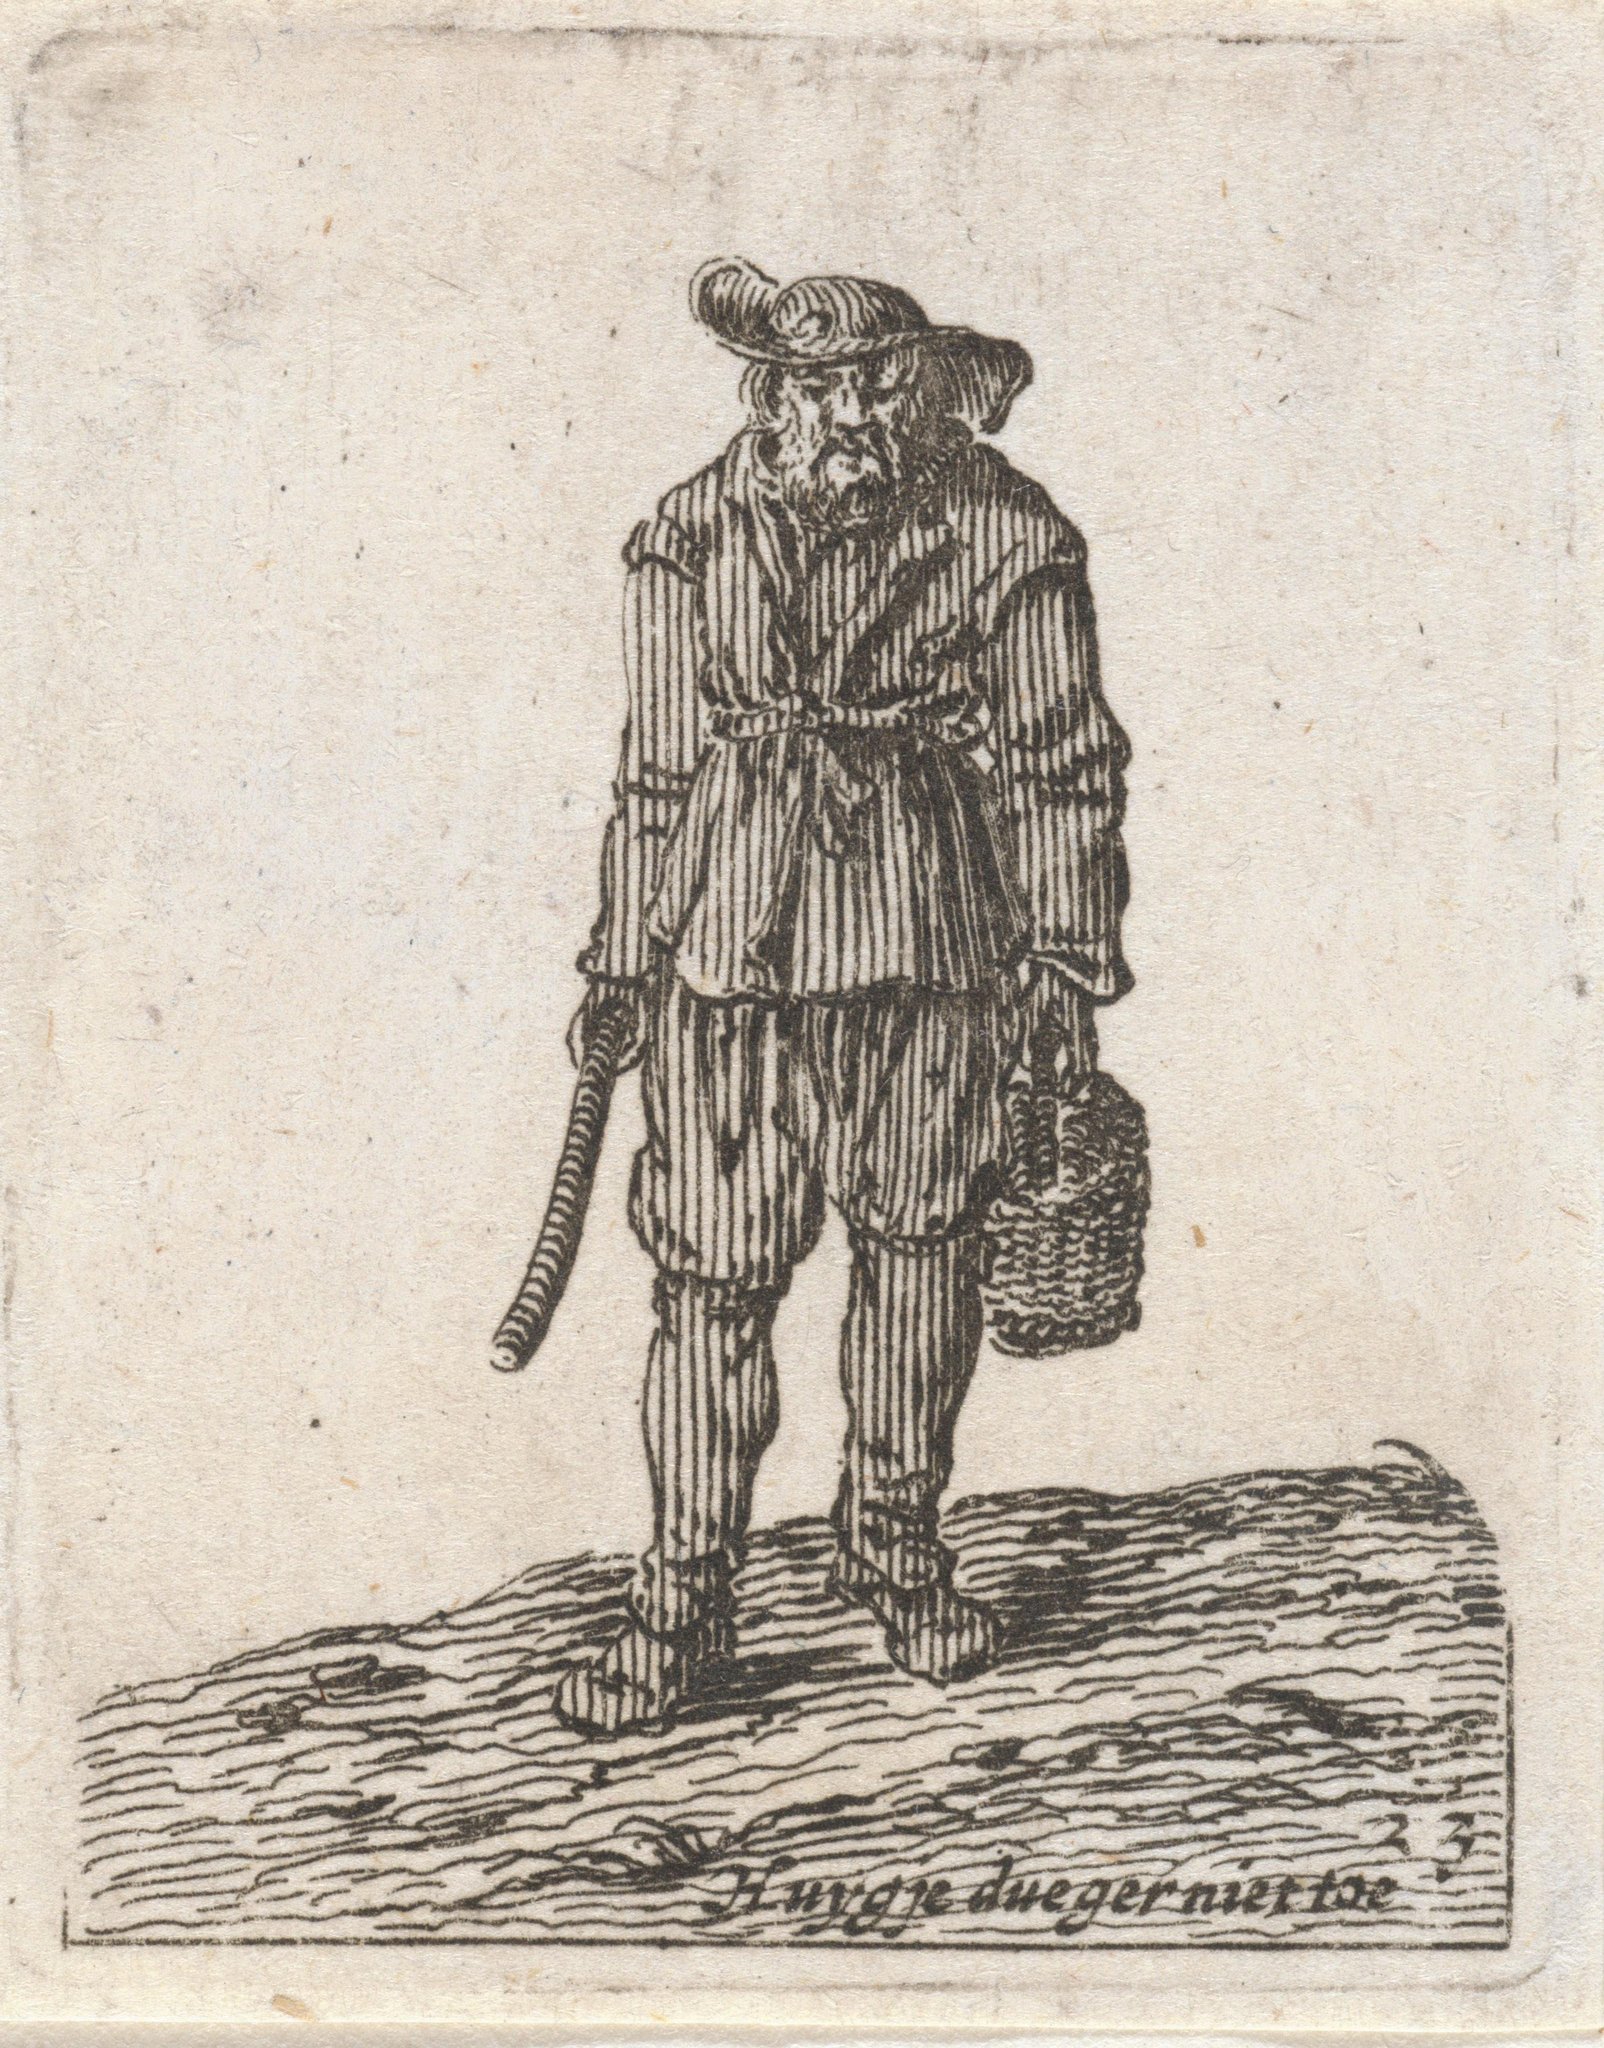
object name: print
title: Man met stok en mand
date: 1630-1706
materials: paper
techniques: etching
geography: netherlands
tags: head-gear: hat (+ men's clothes)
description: Een man met een hoed op het hoofd en in de handen een mand en een stok. De prent maakt deel uit van een serie van 32 prenten met genretaferelen.